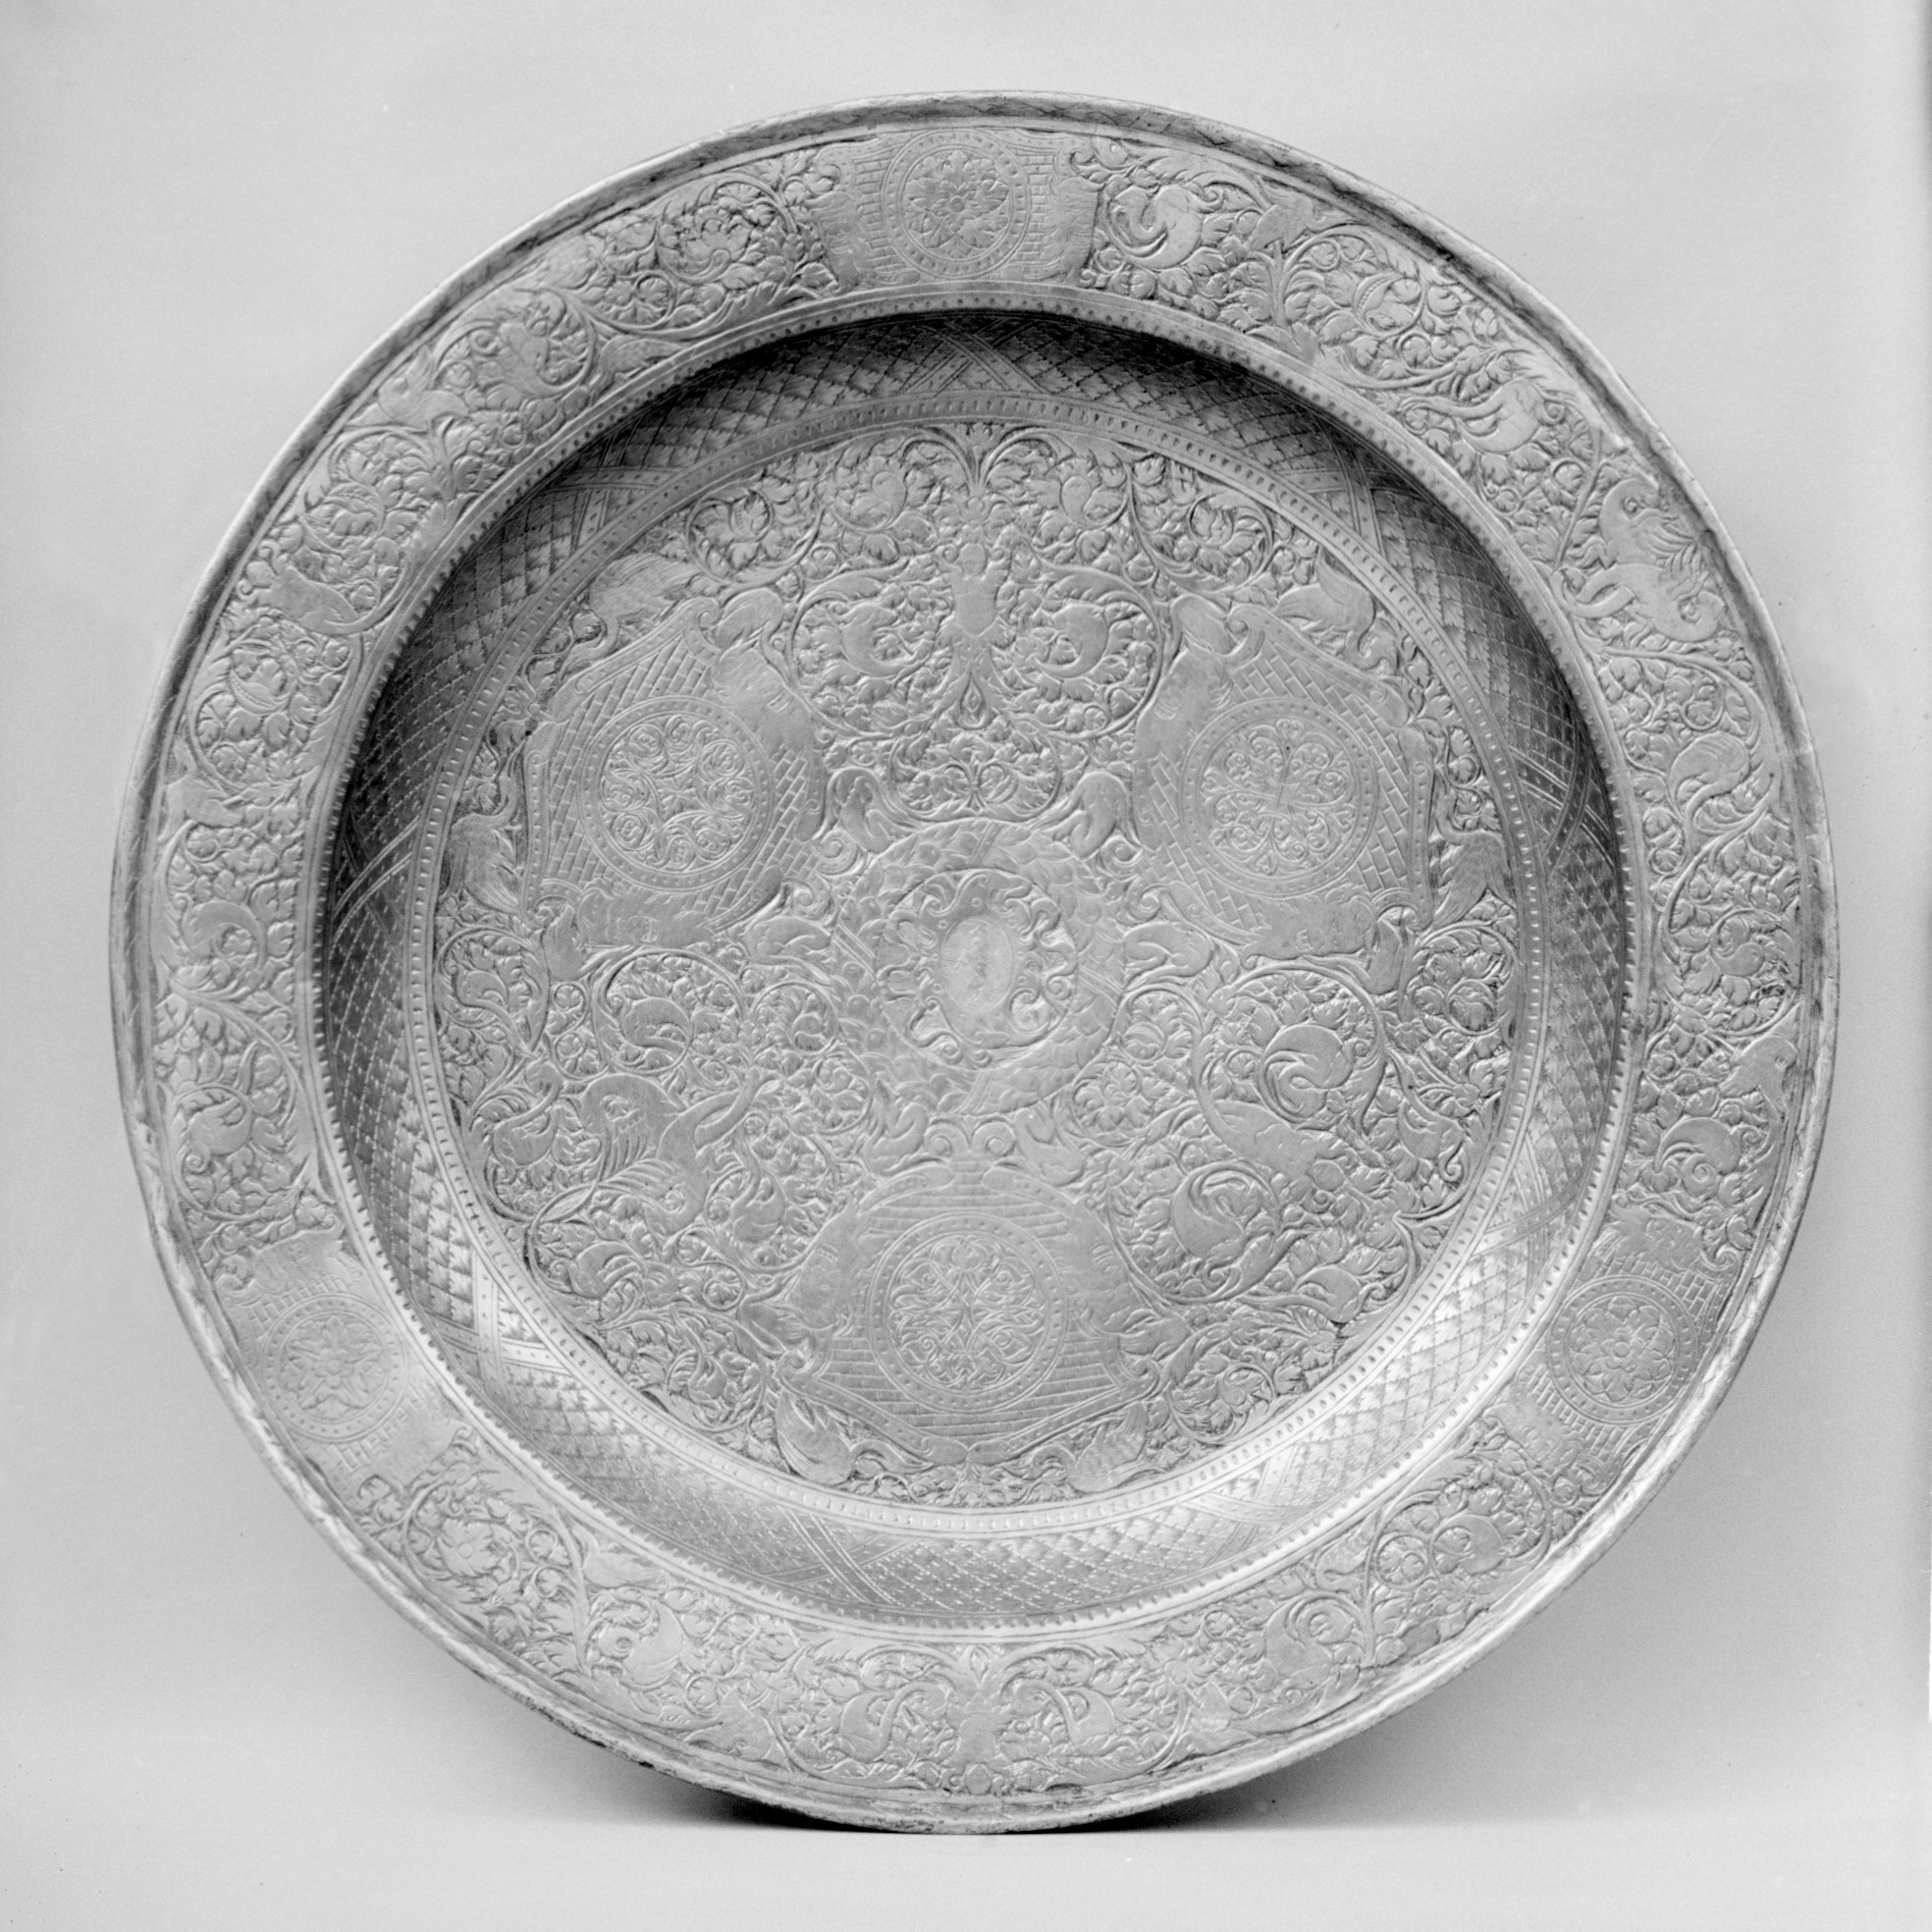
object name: plateau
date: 1601-1700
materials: copper, gilt